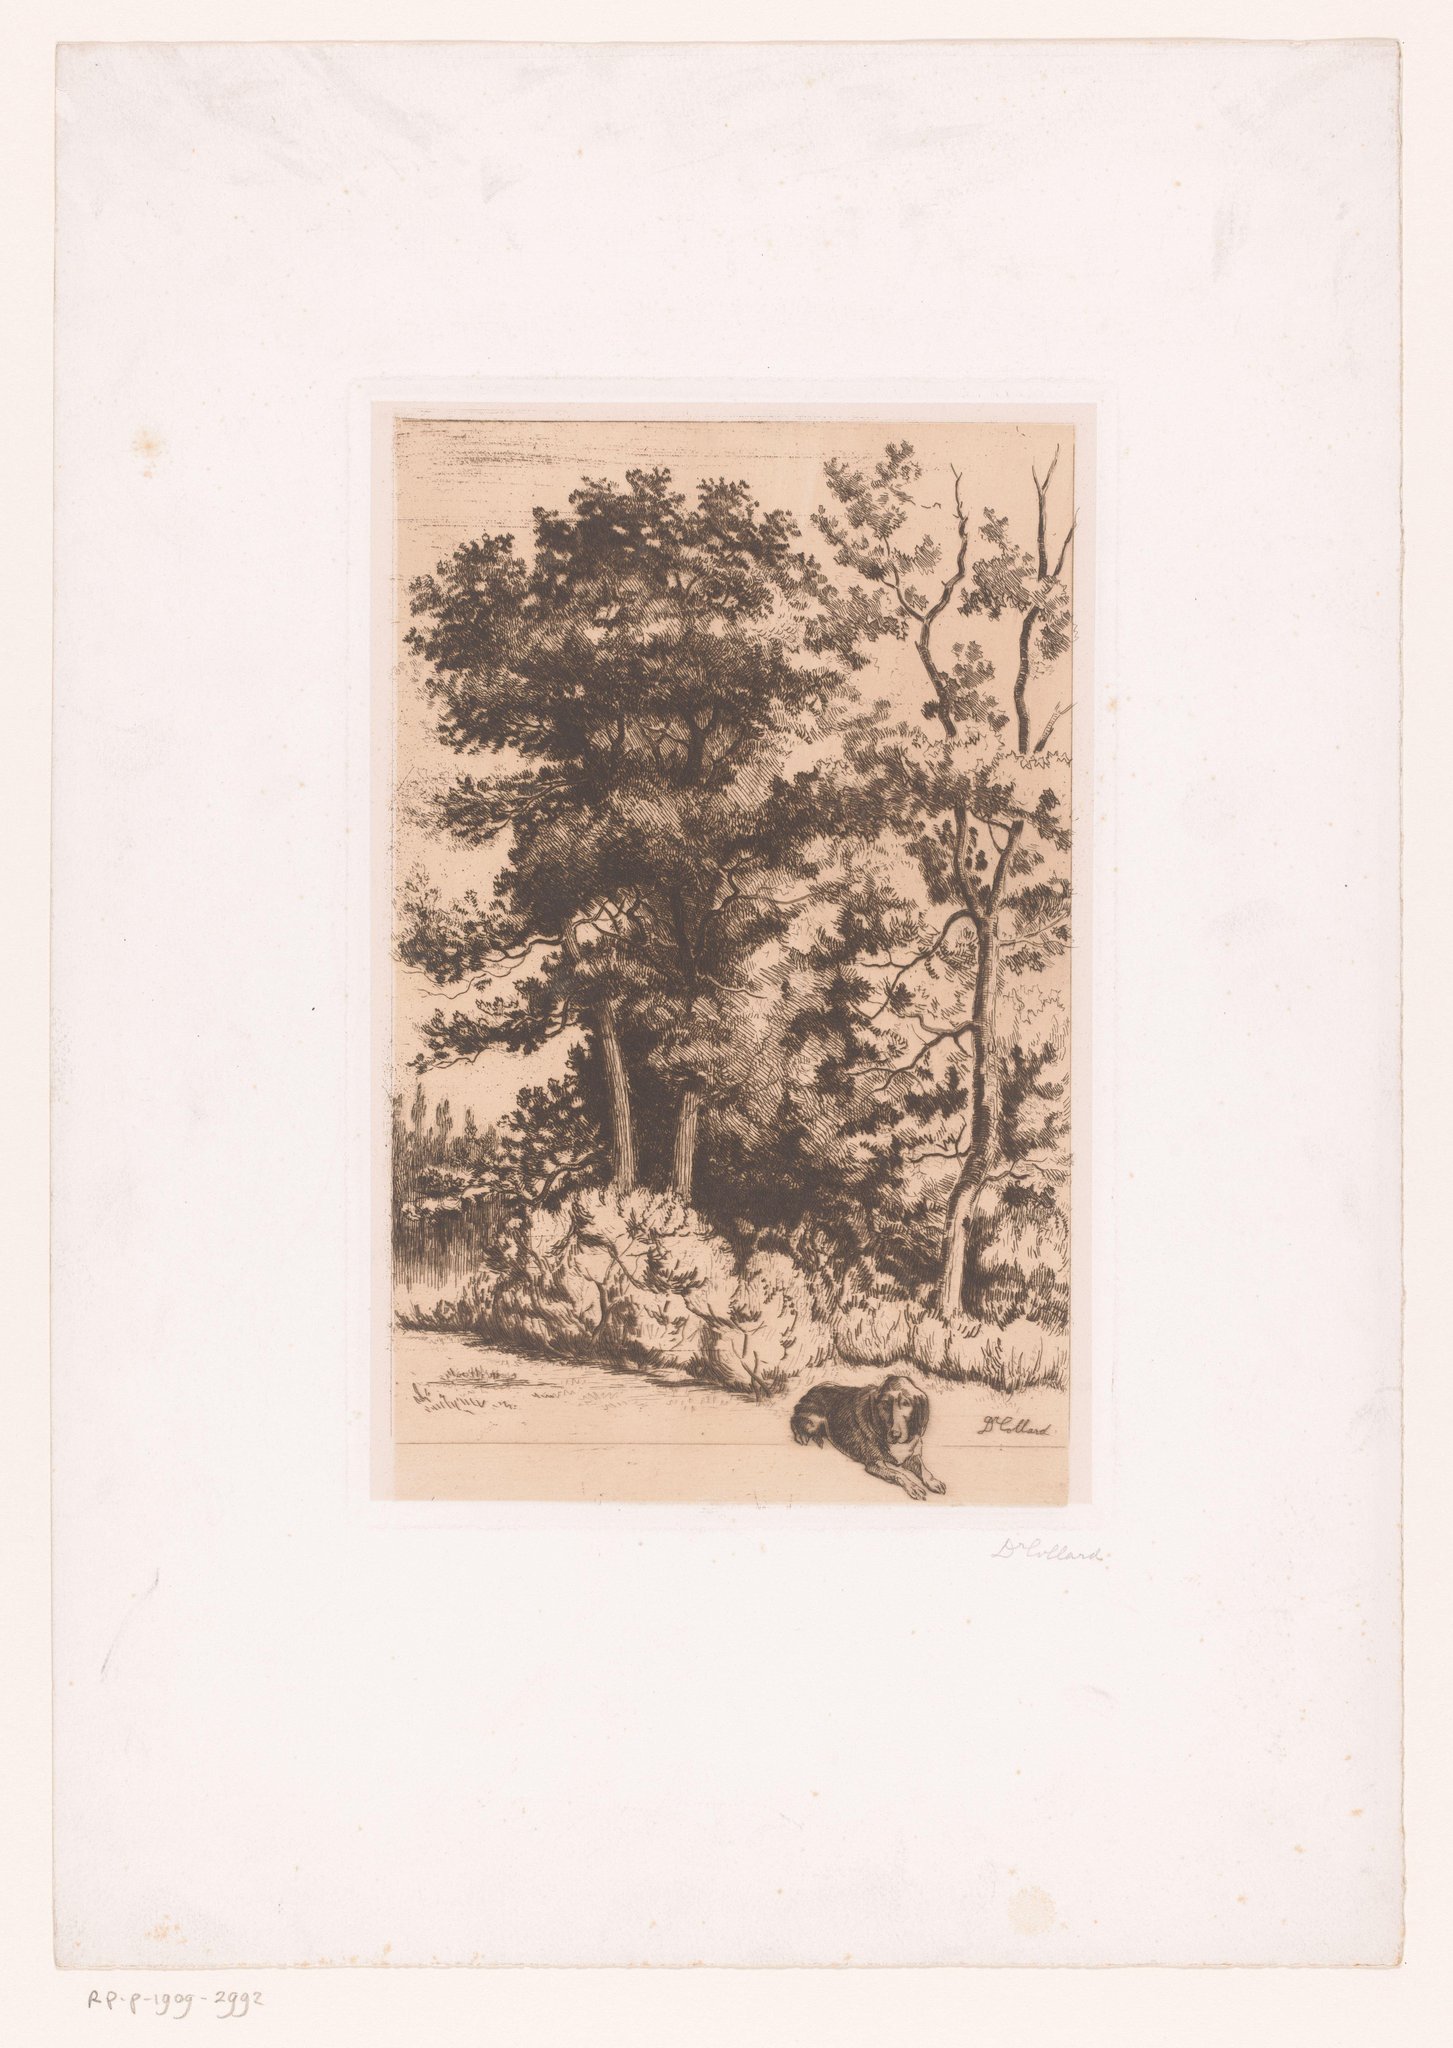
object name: print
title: Gezicht op een bos waarvoor een hond zit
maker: armand collard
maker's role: print maker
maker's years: 1838-1910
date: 1848-1909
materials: paper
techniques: etching, intaglio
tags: forest, wood, dog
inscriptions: collector's mark: Lugt 2228